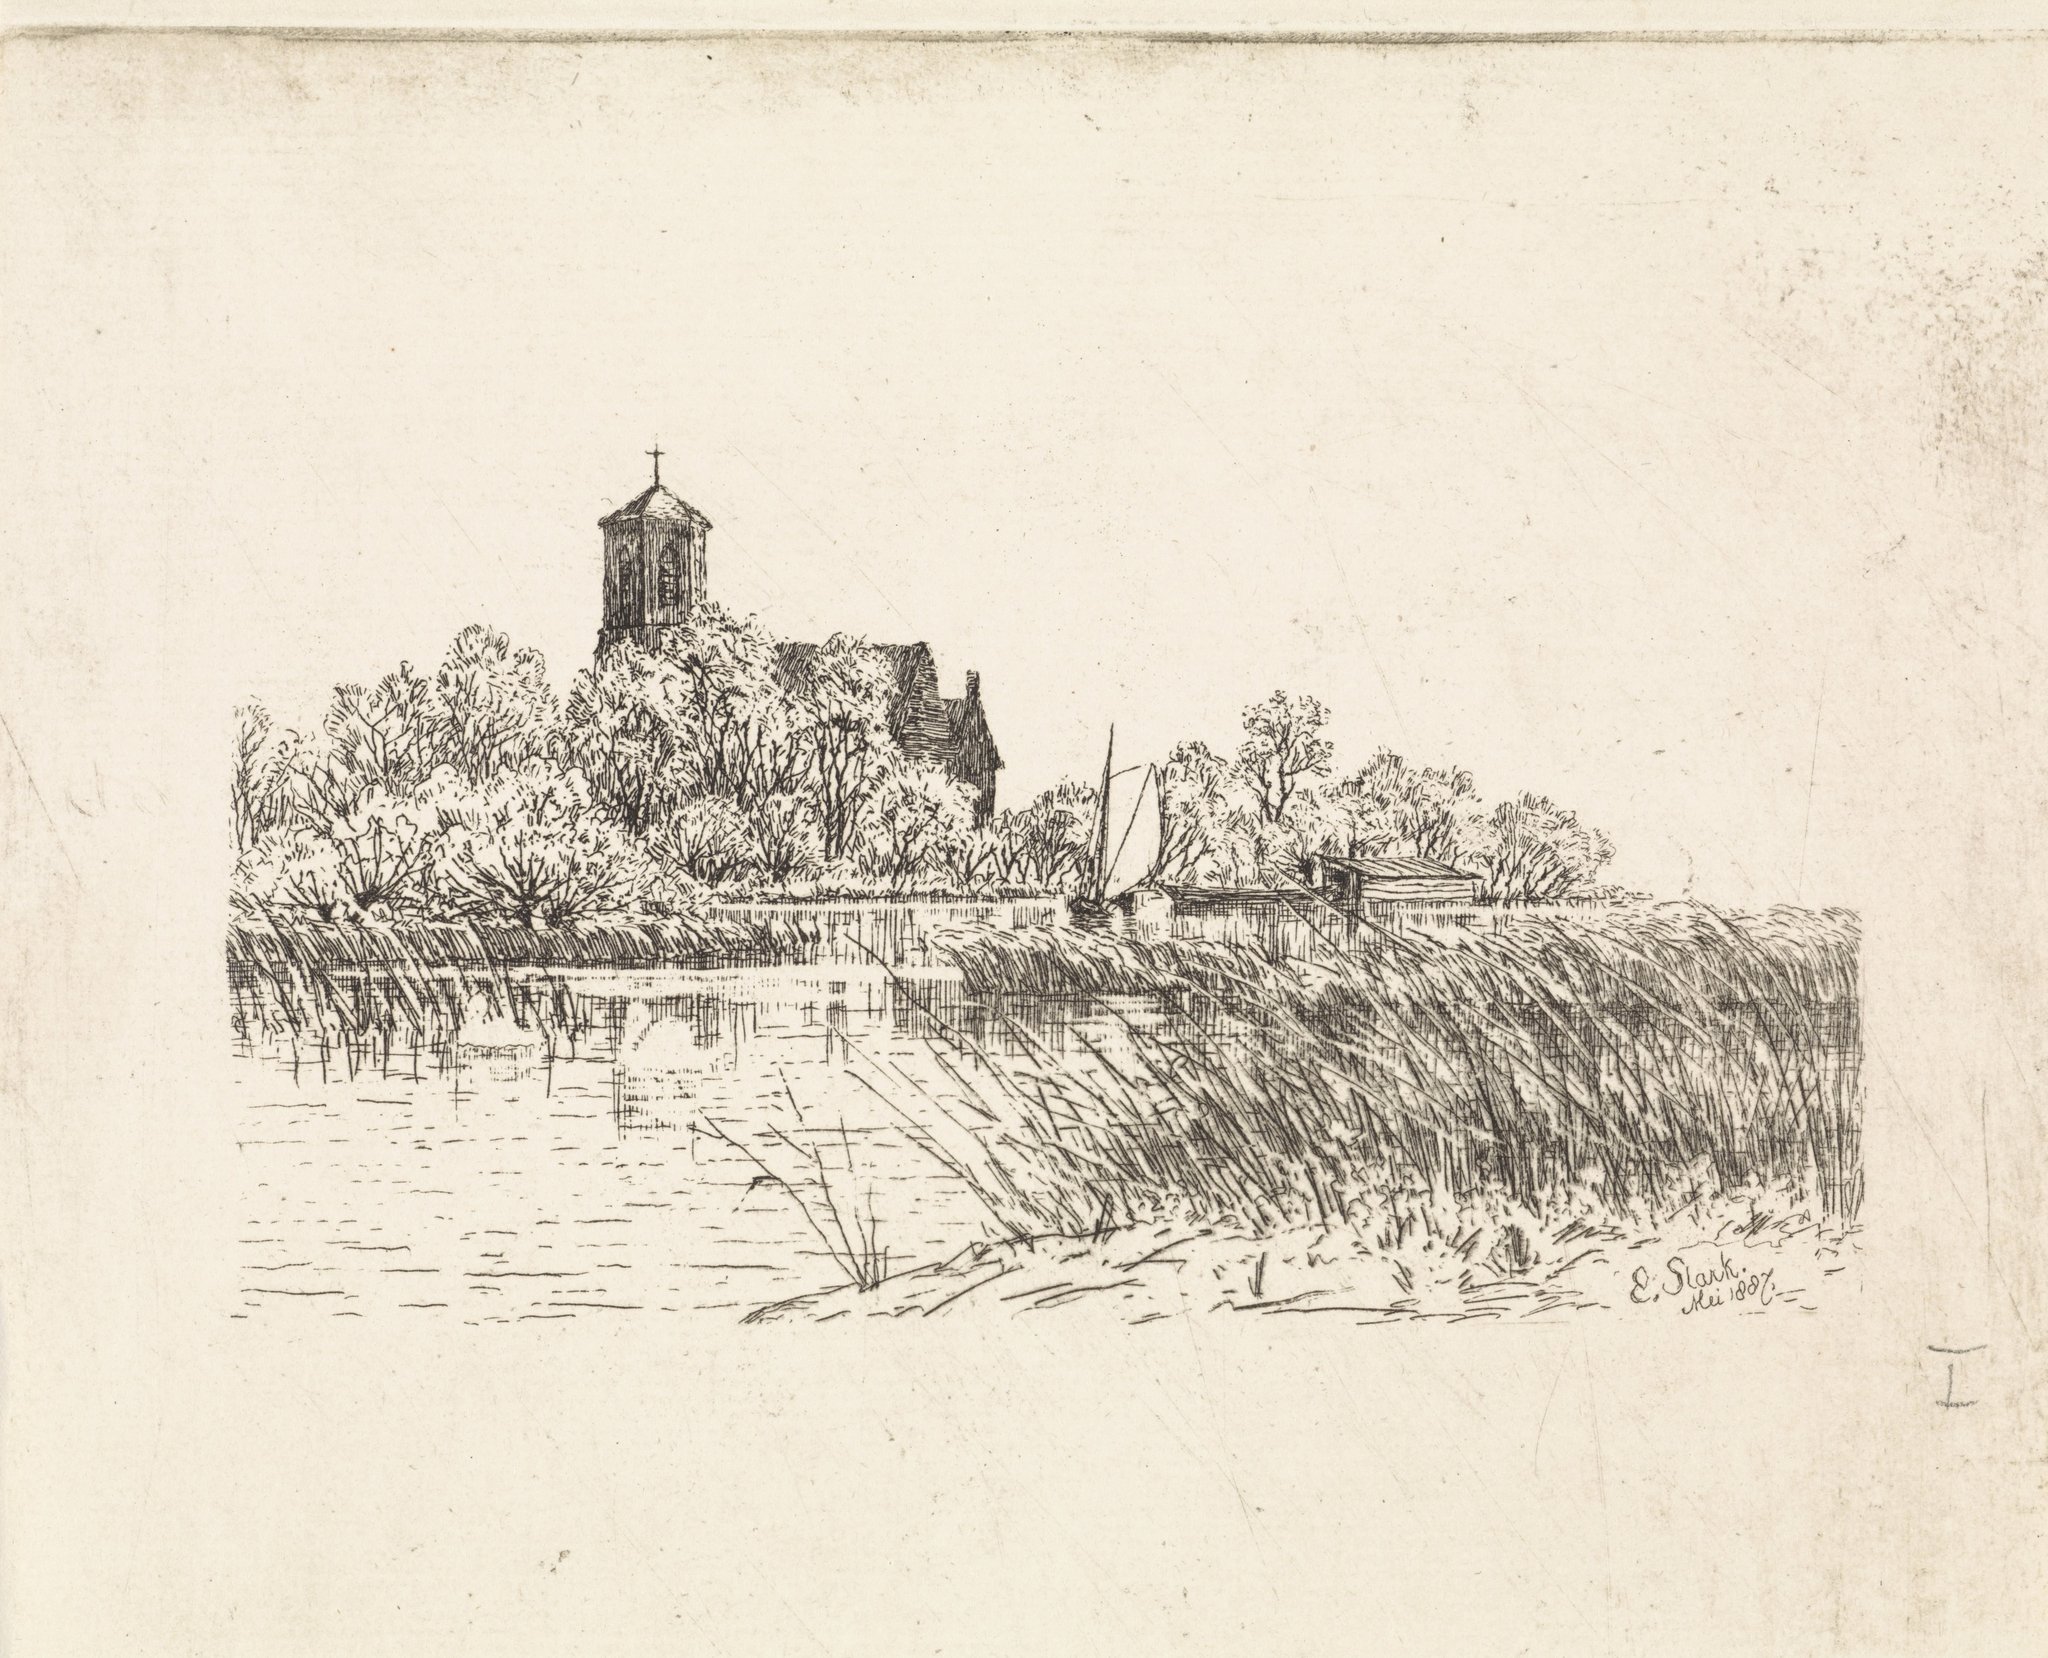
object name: print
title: Gezicht op de Sint Urbanuskerk te Bovenkerk met op het water een zeilscheepje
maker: elias stark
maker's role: draughtsman, print maker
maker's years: 1849-1933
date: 1805-1887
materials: paper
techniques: etching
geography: nieuwer-amstel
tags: church (exterior)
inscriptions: collector's mark: Lugt 2228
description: Gezicht op de St. Urbanuskerk te Bovenkerk met op de voorgrond op het water een zeilscheepje en zwanen.